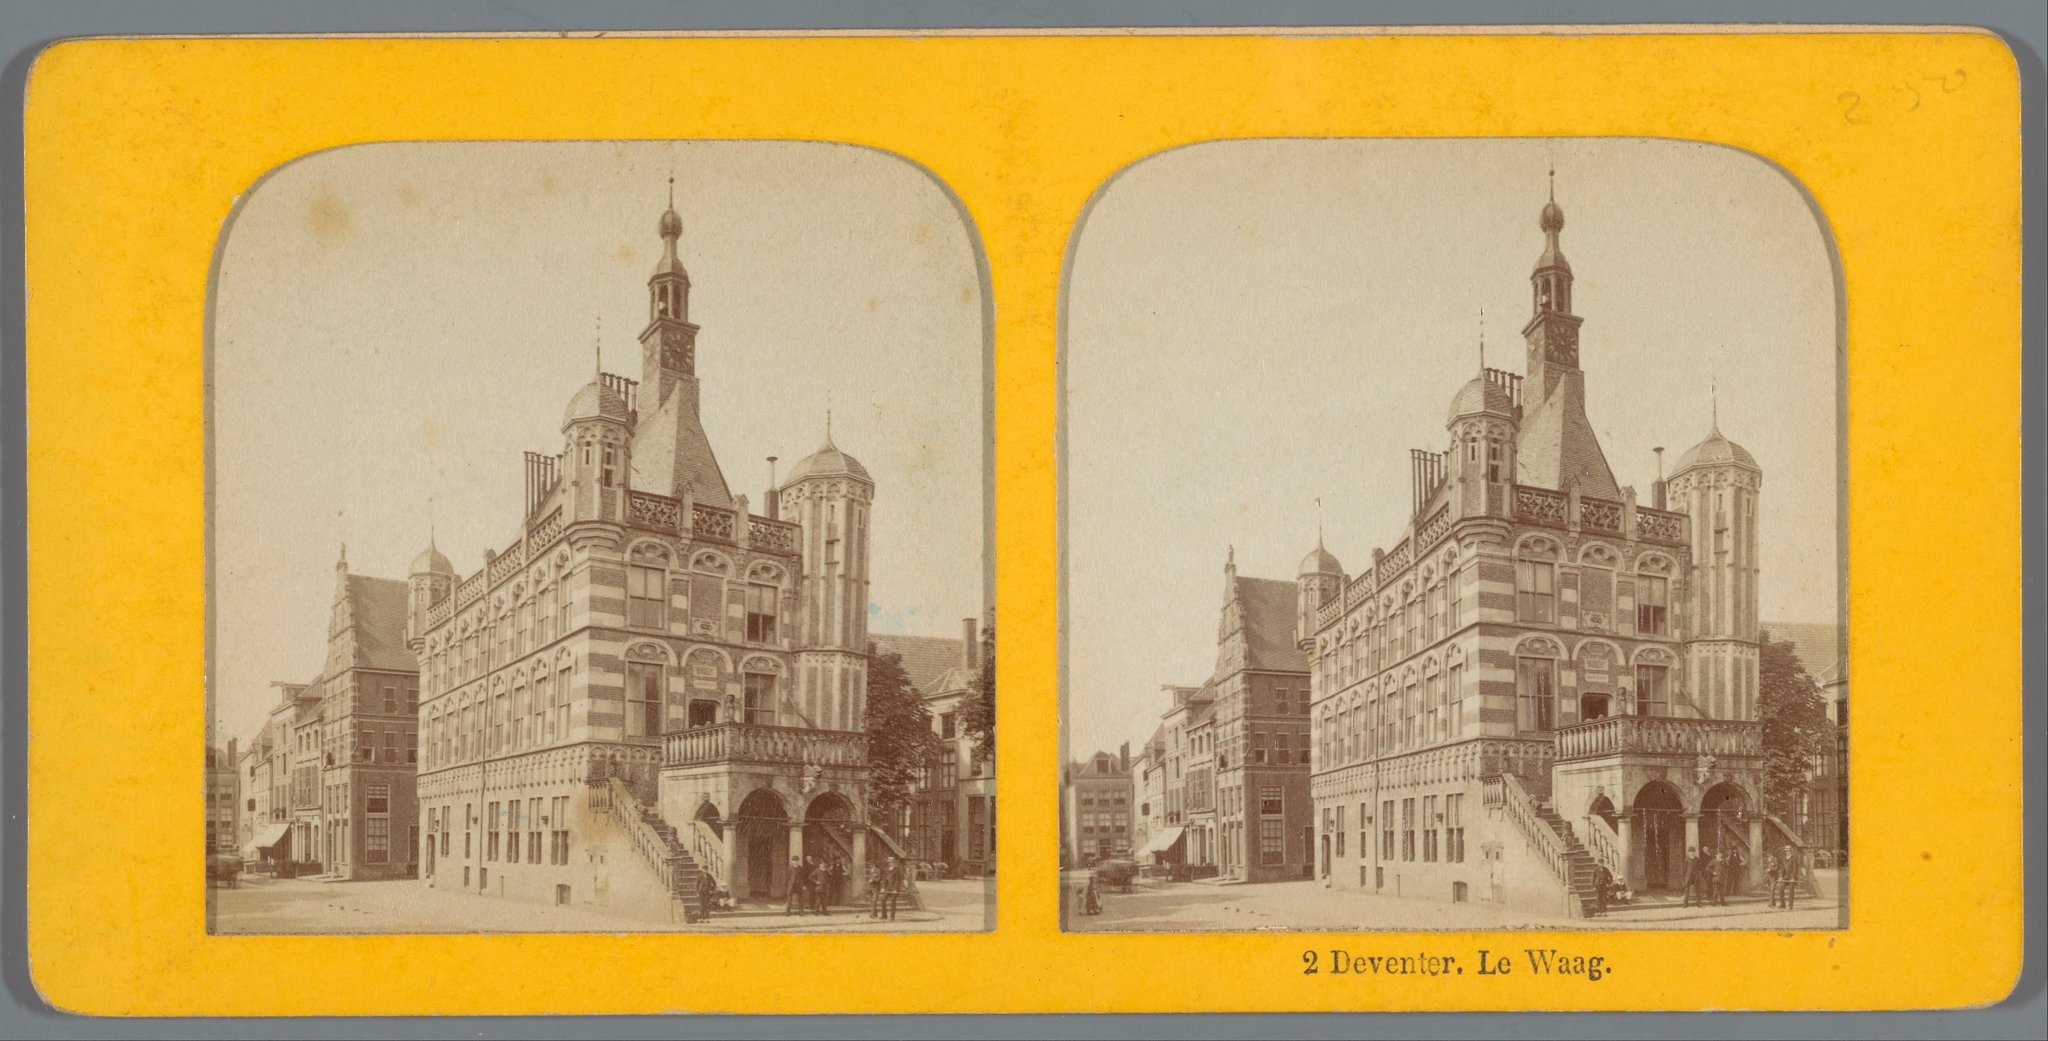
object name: tissue stereograph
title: Deventer. Le Waag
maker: Anonymous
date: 1855-1875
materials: cardboard, paper, photographic support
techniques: albumen print, cutting, hand coloring, perforating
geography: deventer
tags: weigh-house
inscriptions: number: ‘9’, number: ‘2’